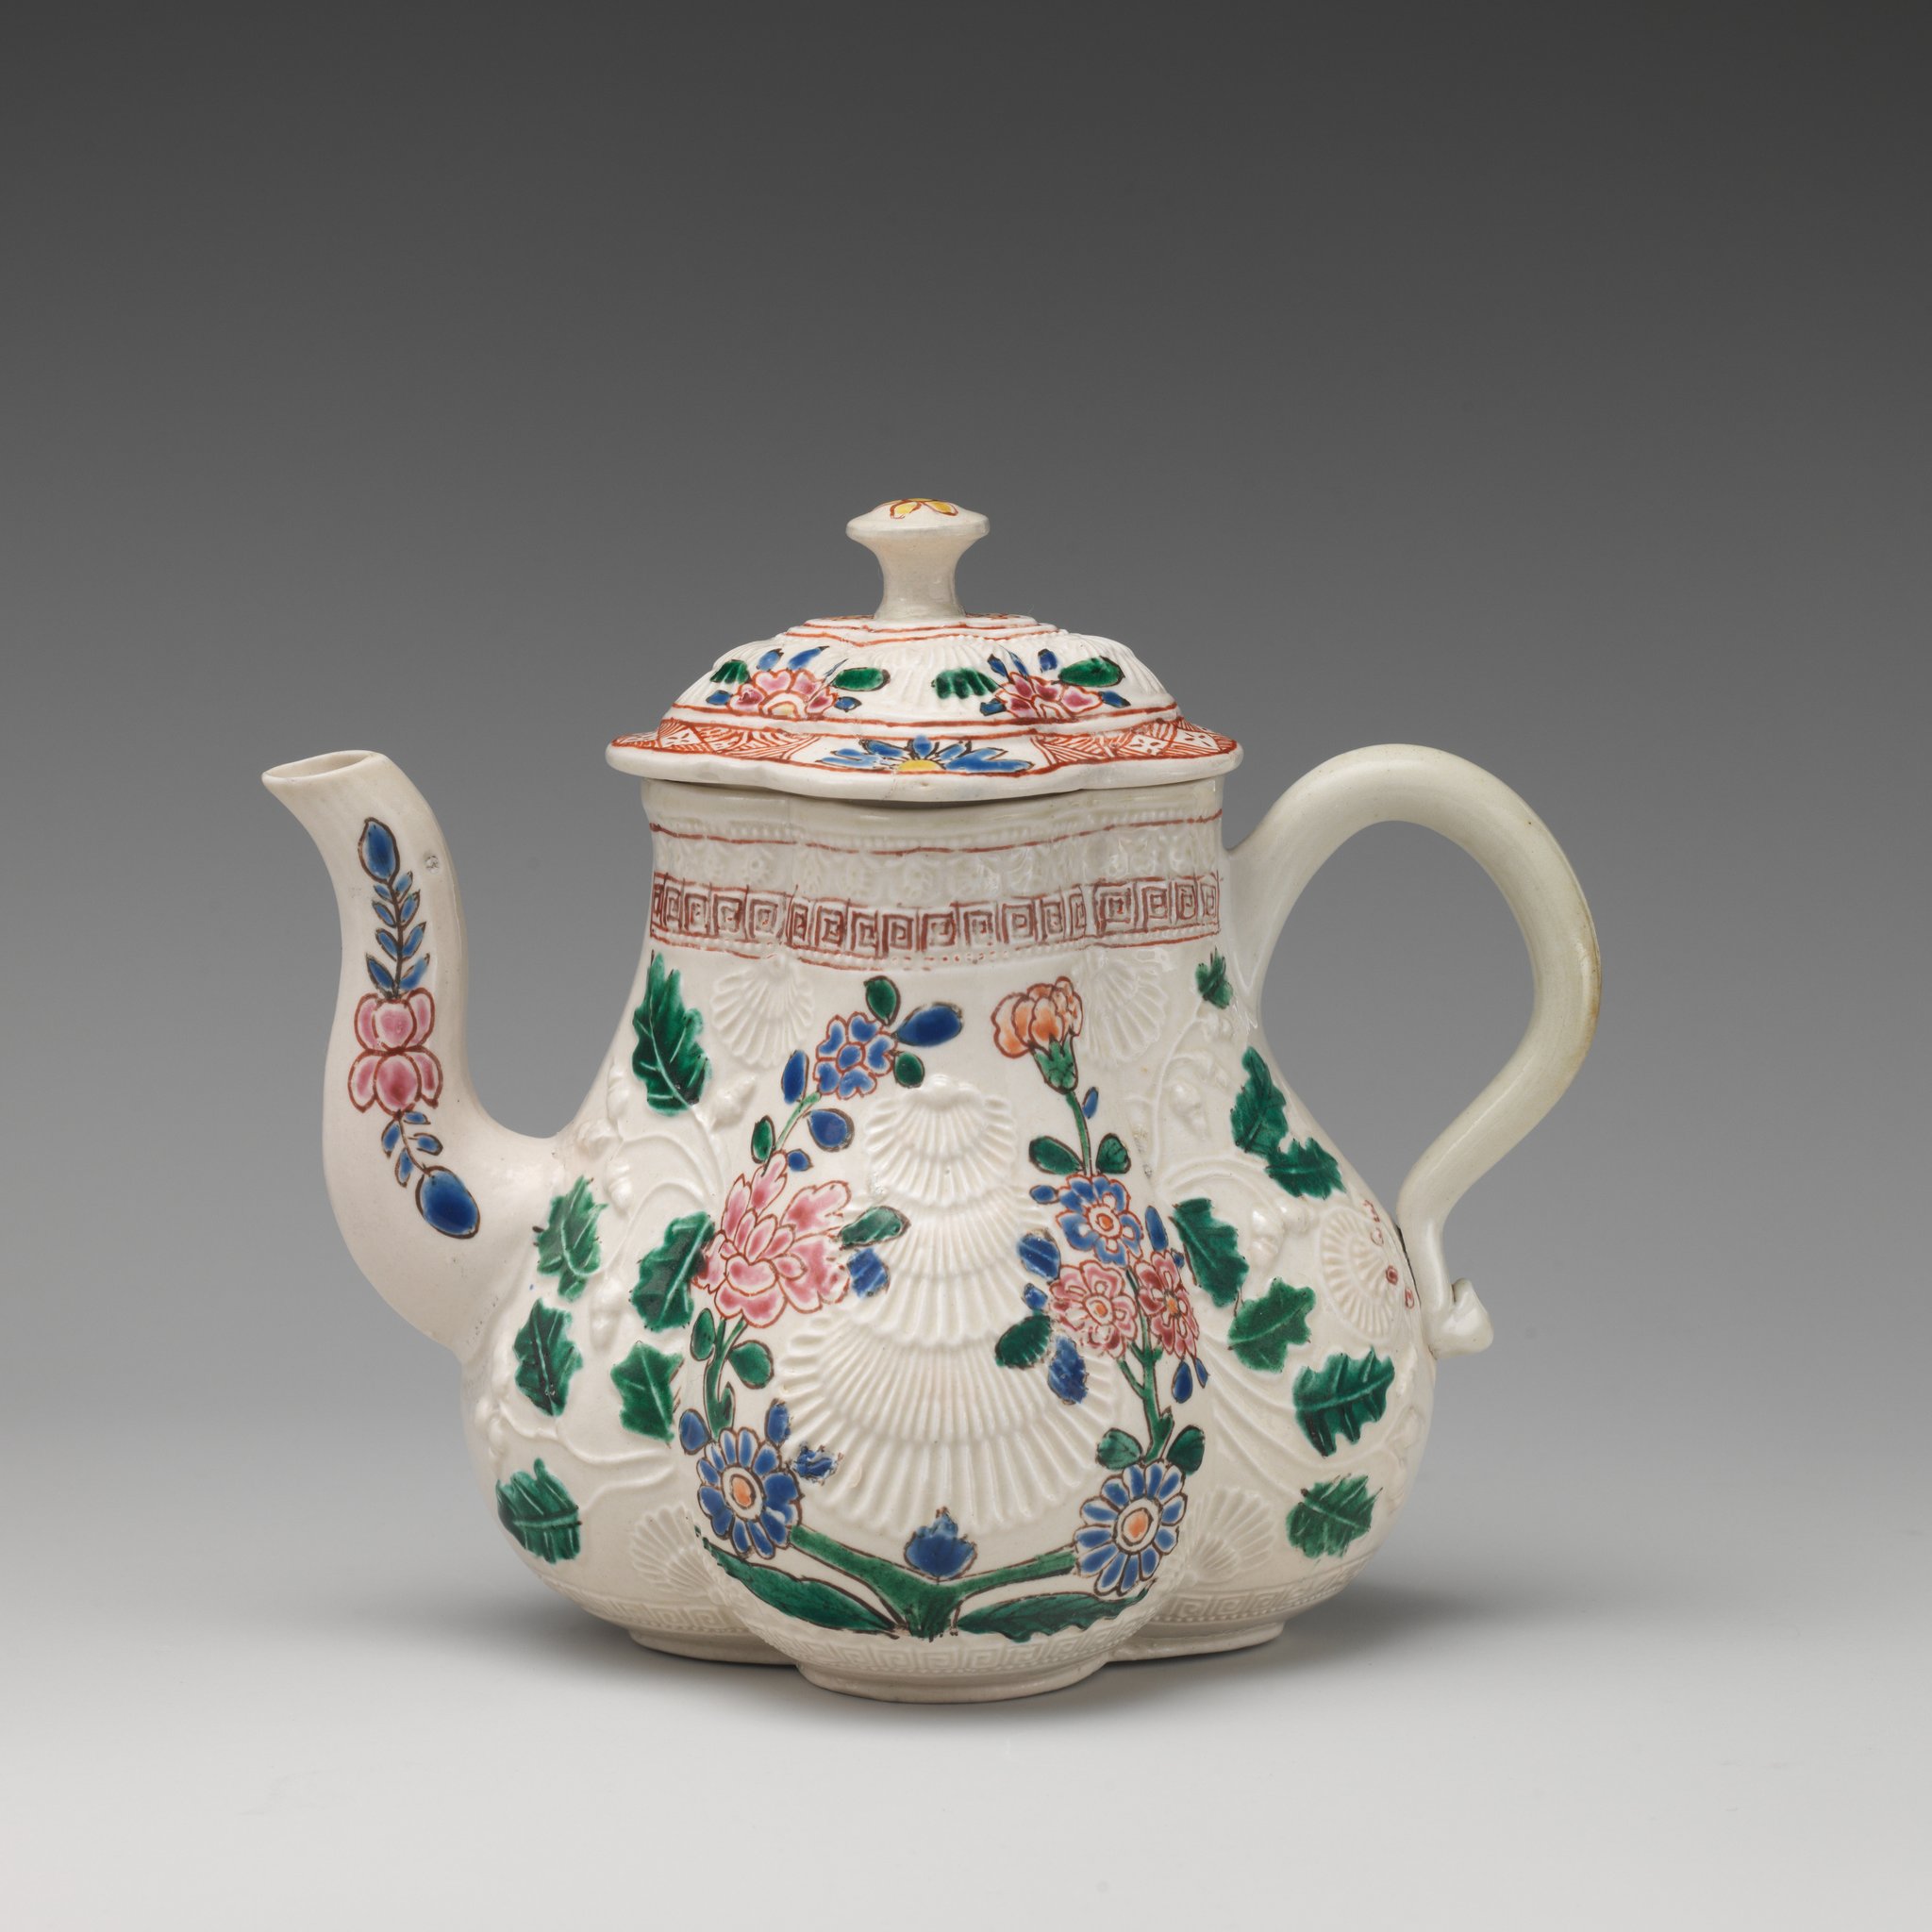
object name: teapot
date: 1750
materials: enamel, stoneware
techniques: salt glaze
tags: flowers,leaves